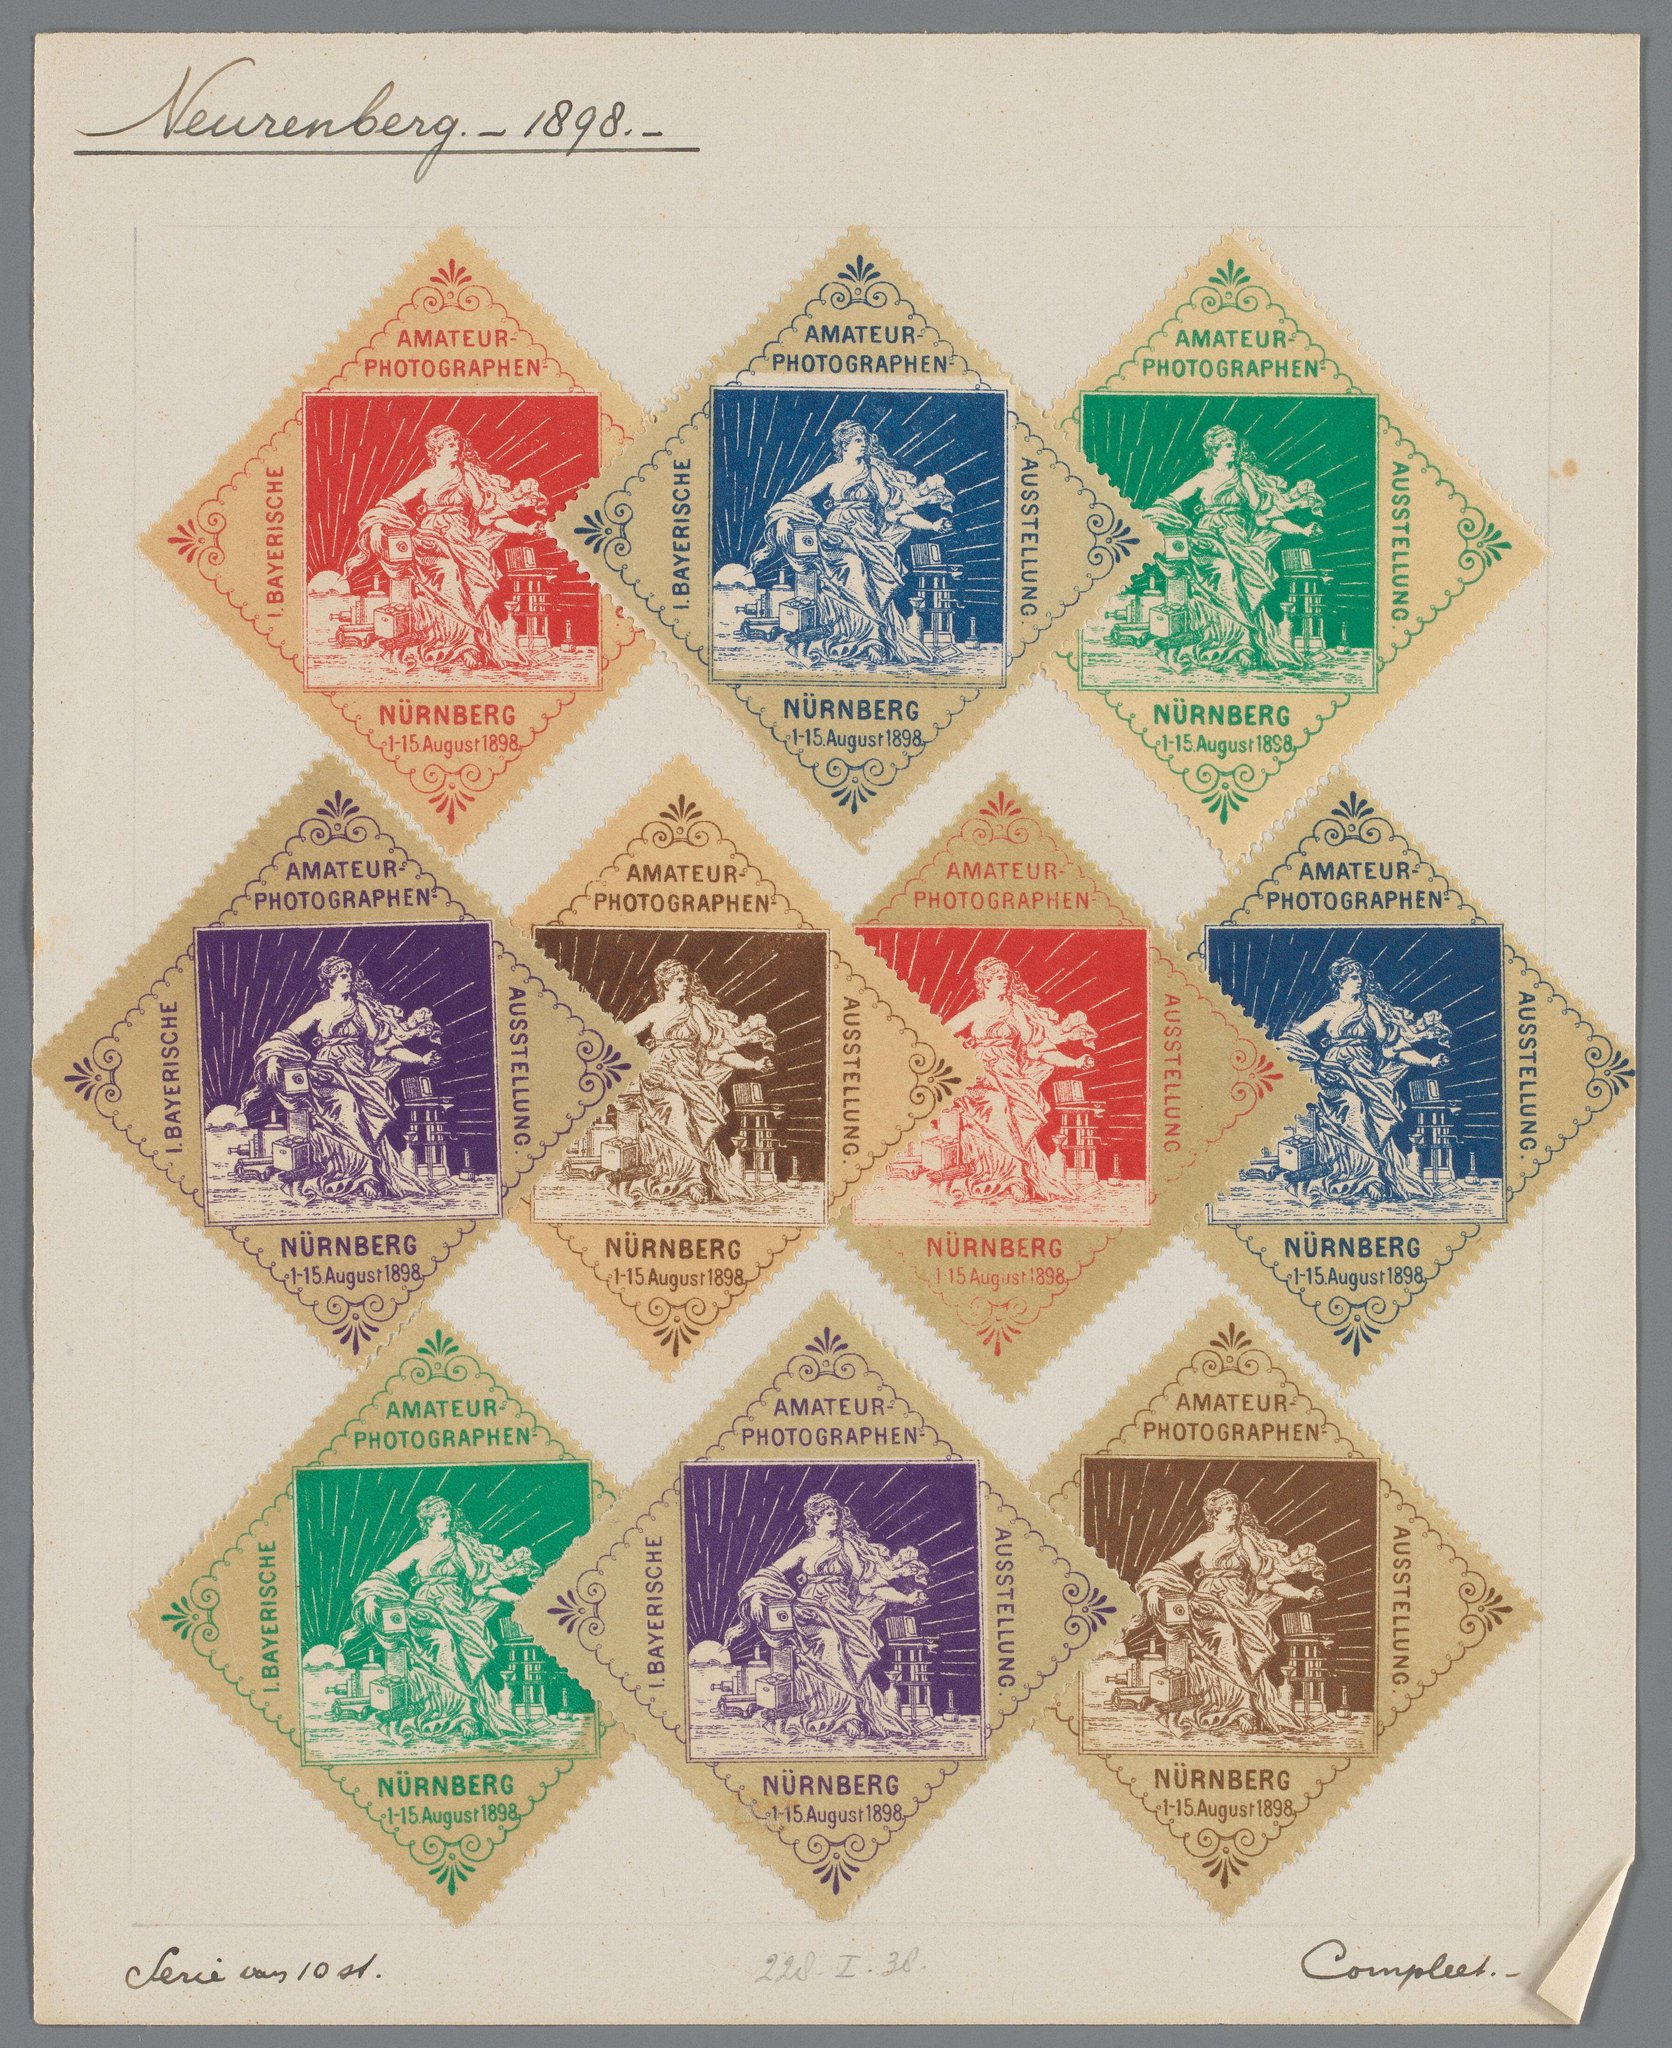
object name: sluitzegel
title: Blad met tien zegels van de I. Bayerische Amateurphotographenausstellung te Neurenberg, voorstellende een godin met camera's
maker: Anonymous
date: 1898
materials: paper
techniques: lithograph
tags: camera ~ photography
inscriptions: stamp: ‘EA’, inscription: ‘Neurenberg.- 1898.-/ Serie van 10 st. Compleet’, number: ‘7.50’, number: ‘228 I. 38’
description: Tien zegels in rood, blauw, groen, paars en bruin.